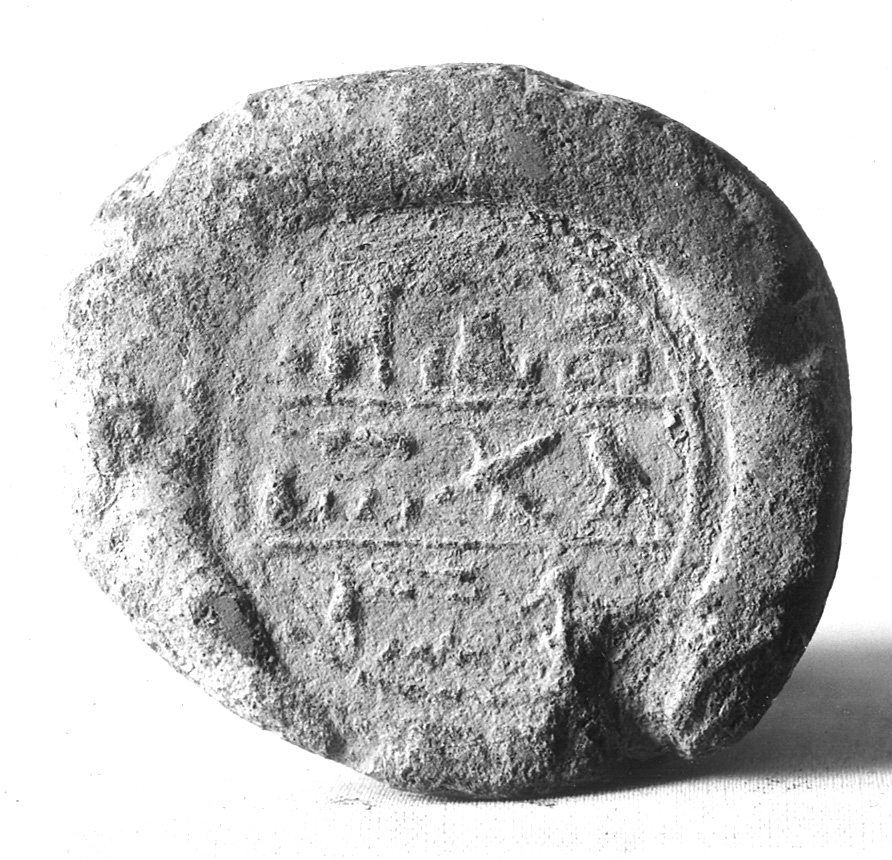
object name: cone, circular impression, pa aten, scribe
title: Funerary Cone of Pa-Aten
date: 1550-1352 BCE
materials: pottery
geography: egypt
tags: hieroglyphs